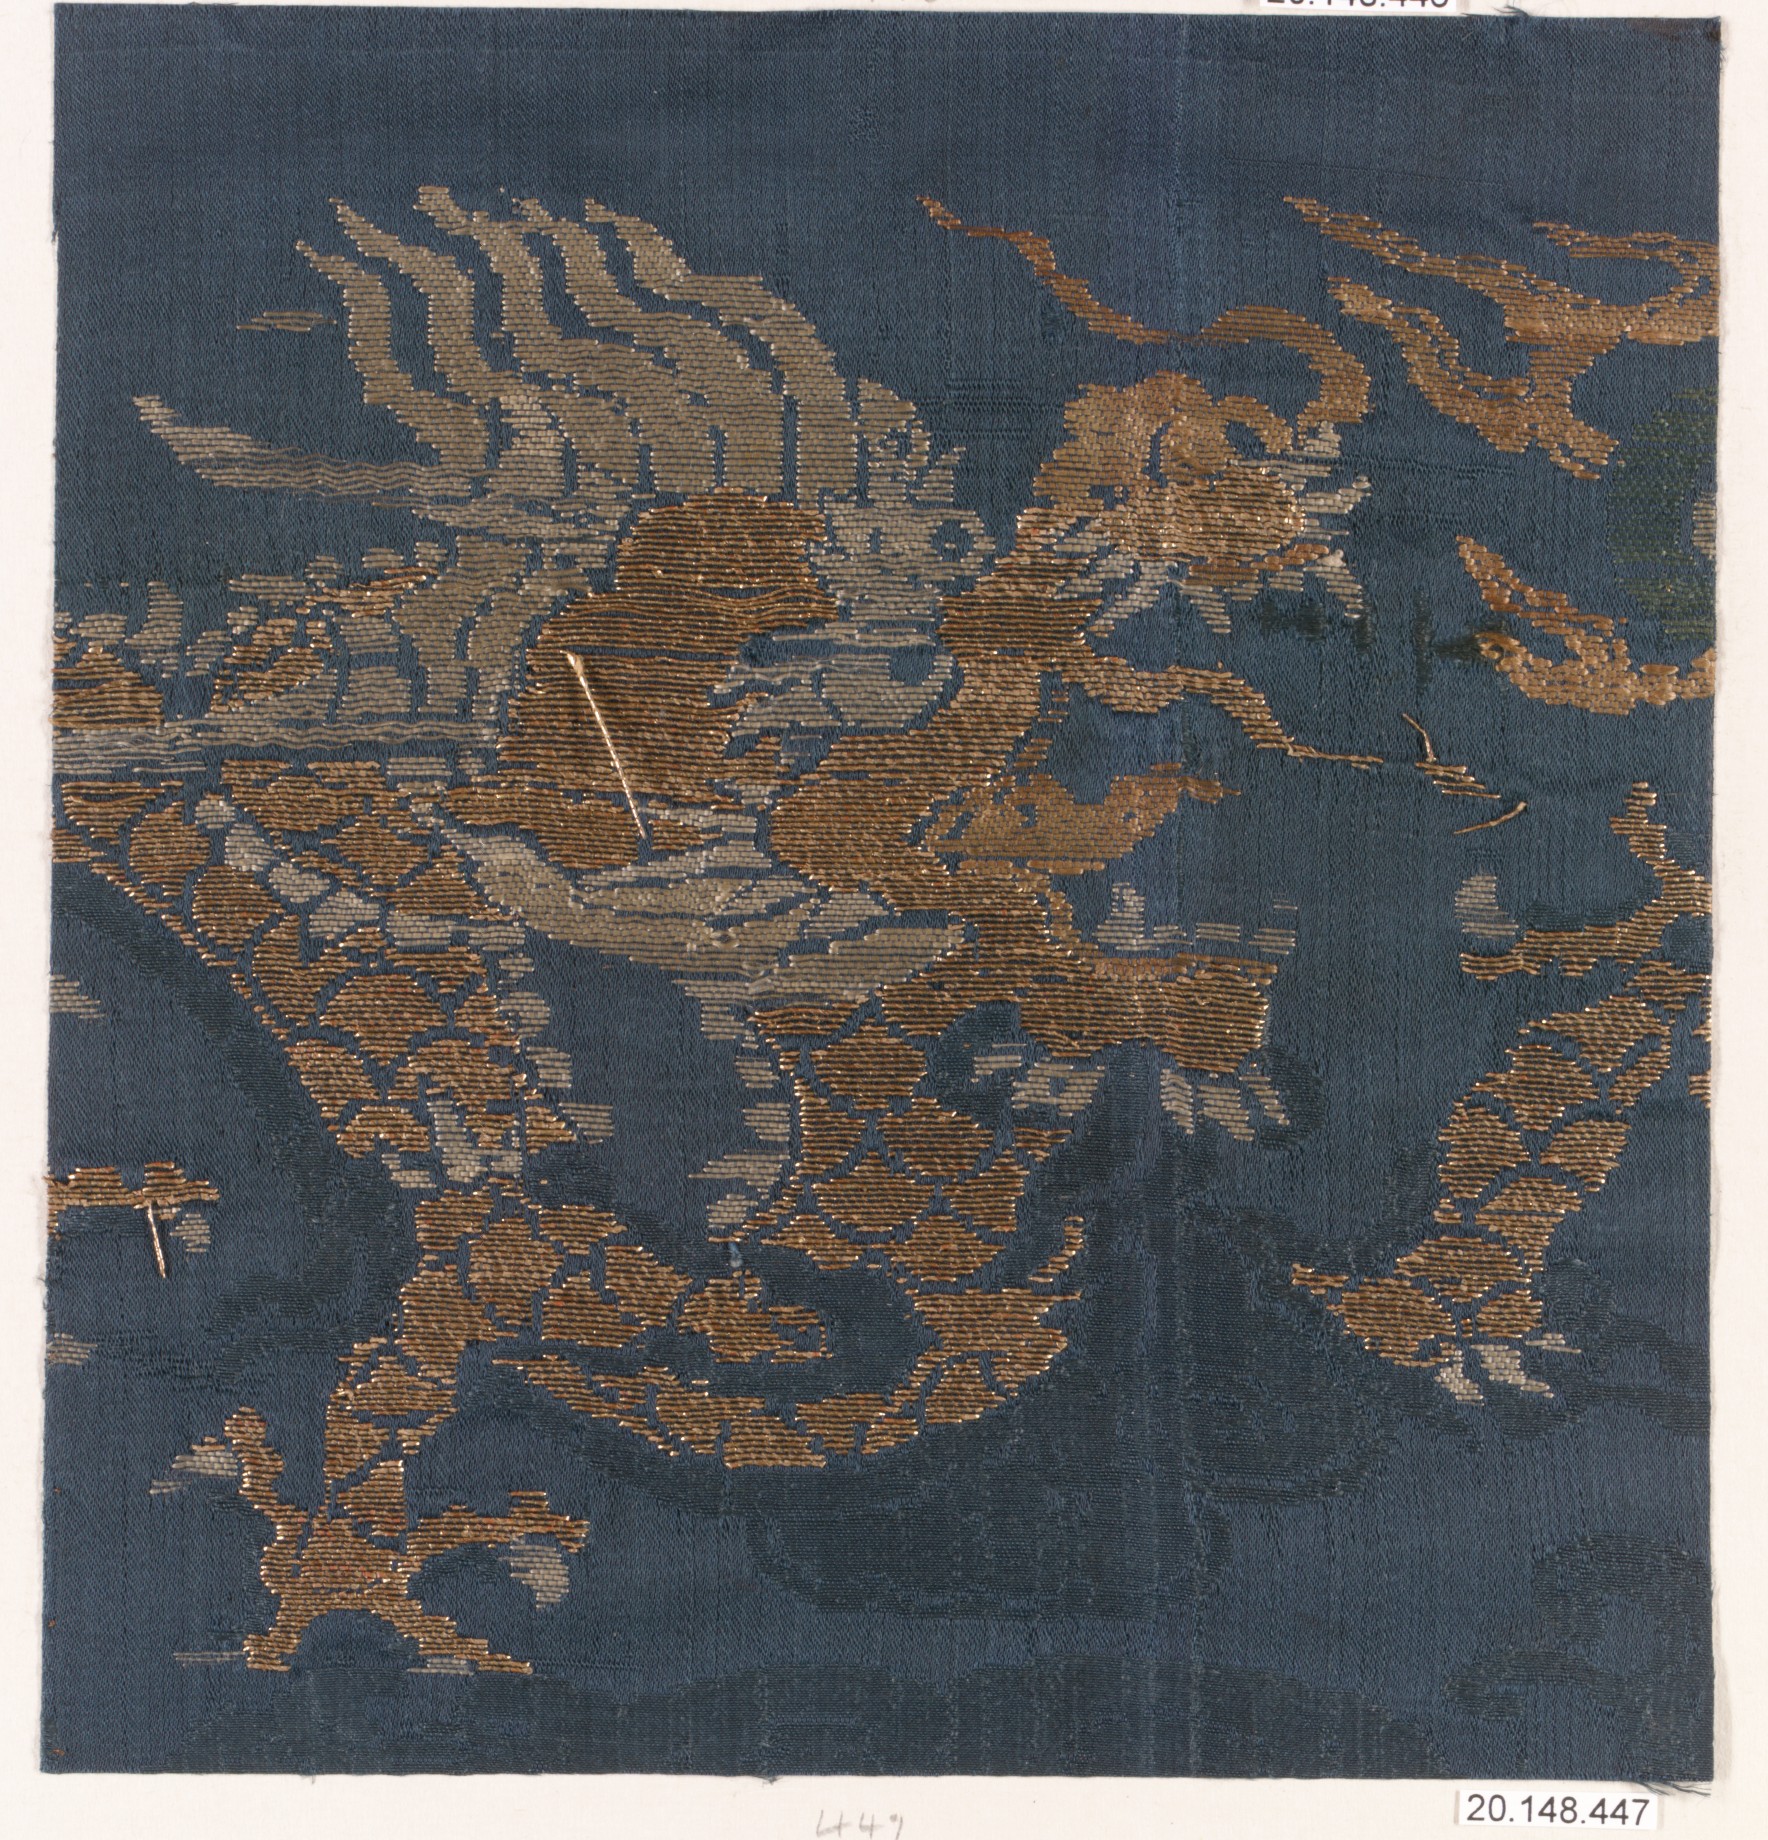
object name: piece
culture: chinese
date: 1601-1700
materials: silk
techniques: compound weave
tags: dragons